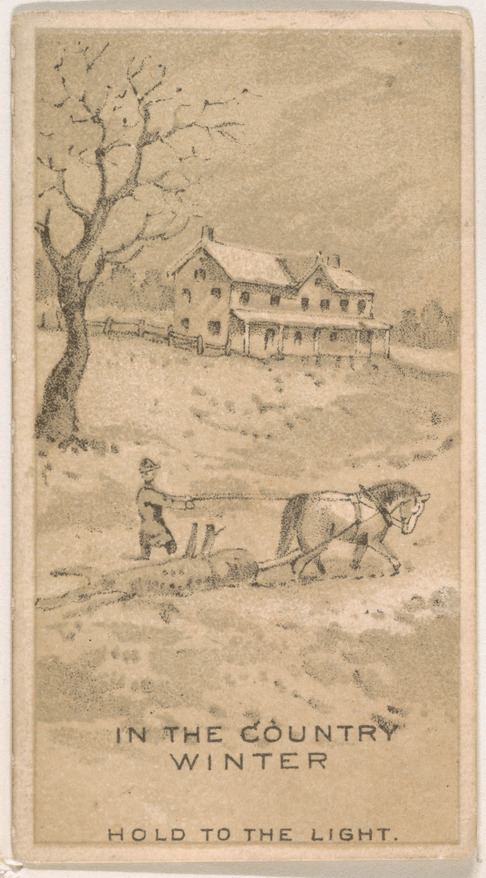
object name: print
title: In the Country Winter, from the Magic Changing Cards series (N223) issued by Kinney Tobacco Company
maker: kinney brothers tobacco company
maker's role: publisher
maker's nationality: american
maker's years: 1869-2011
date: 1889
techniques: color lithograph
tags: houses,men,horses,winter,snow